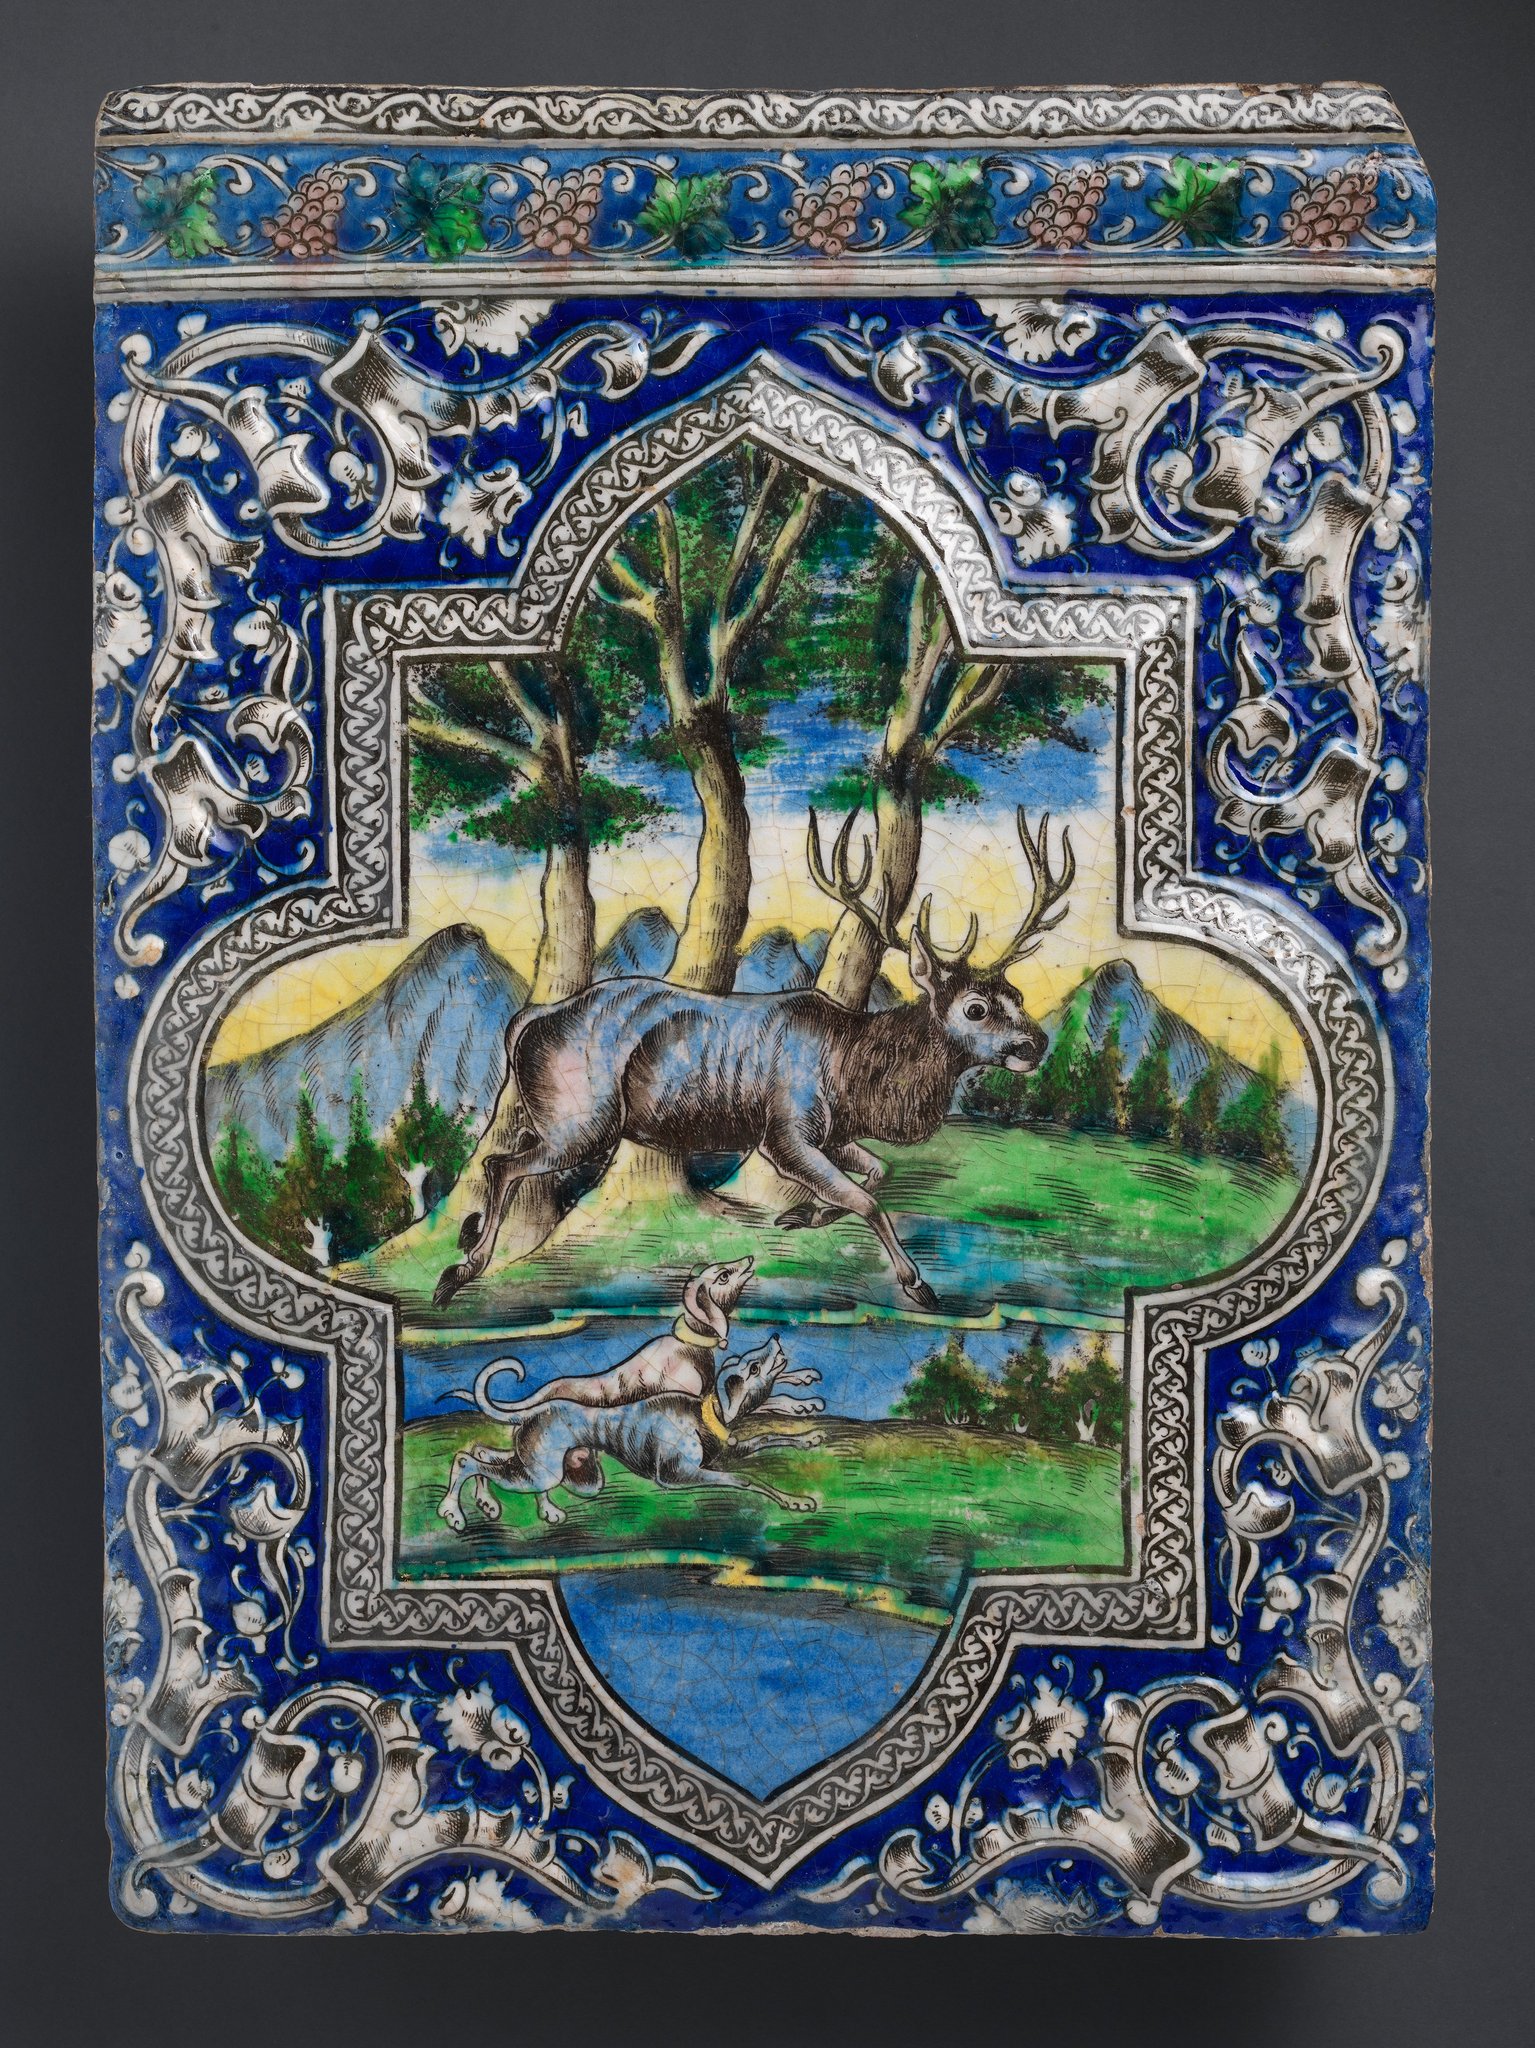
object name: tile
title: Qajar Dado Tile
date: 1801-1900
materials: glaze, stonepaste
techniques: painting, polychrome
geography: iran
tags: deer,dogs,landscapes